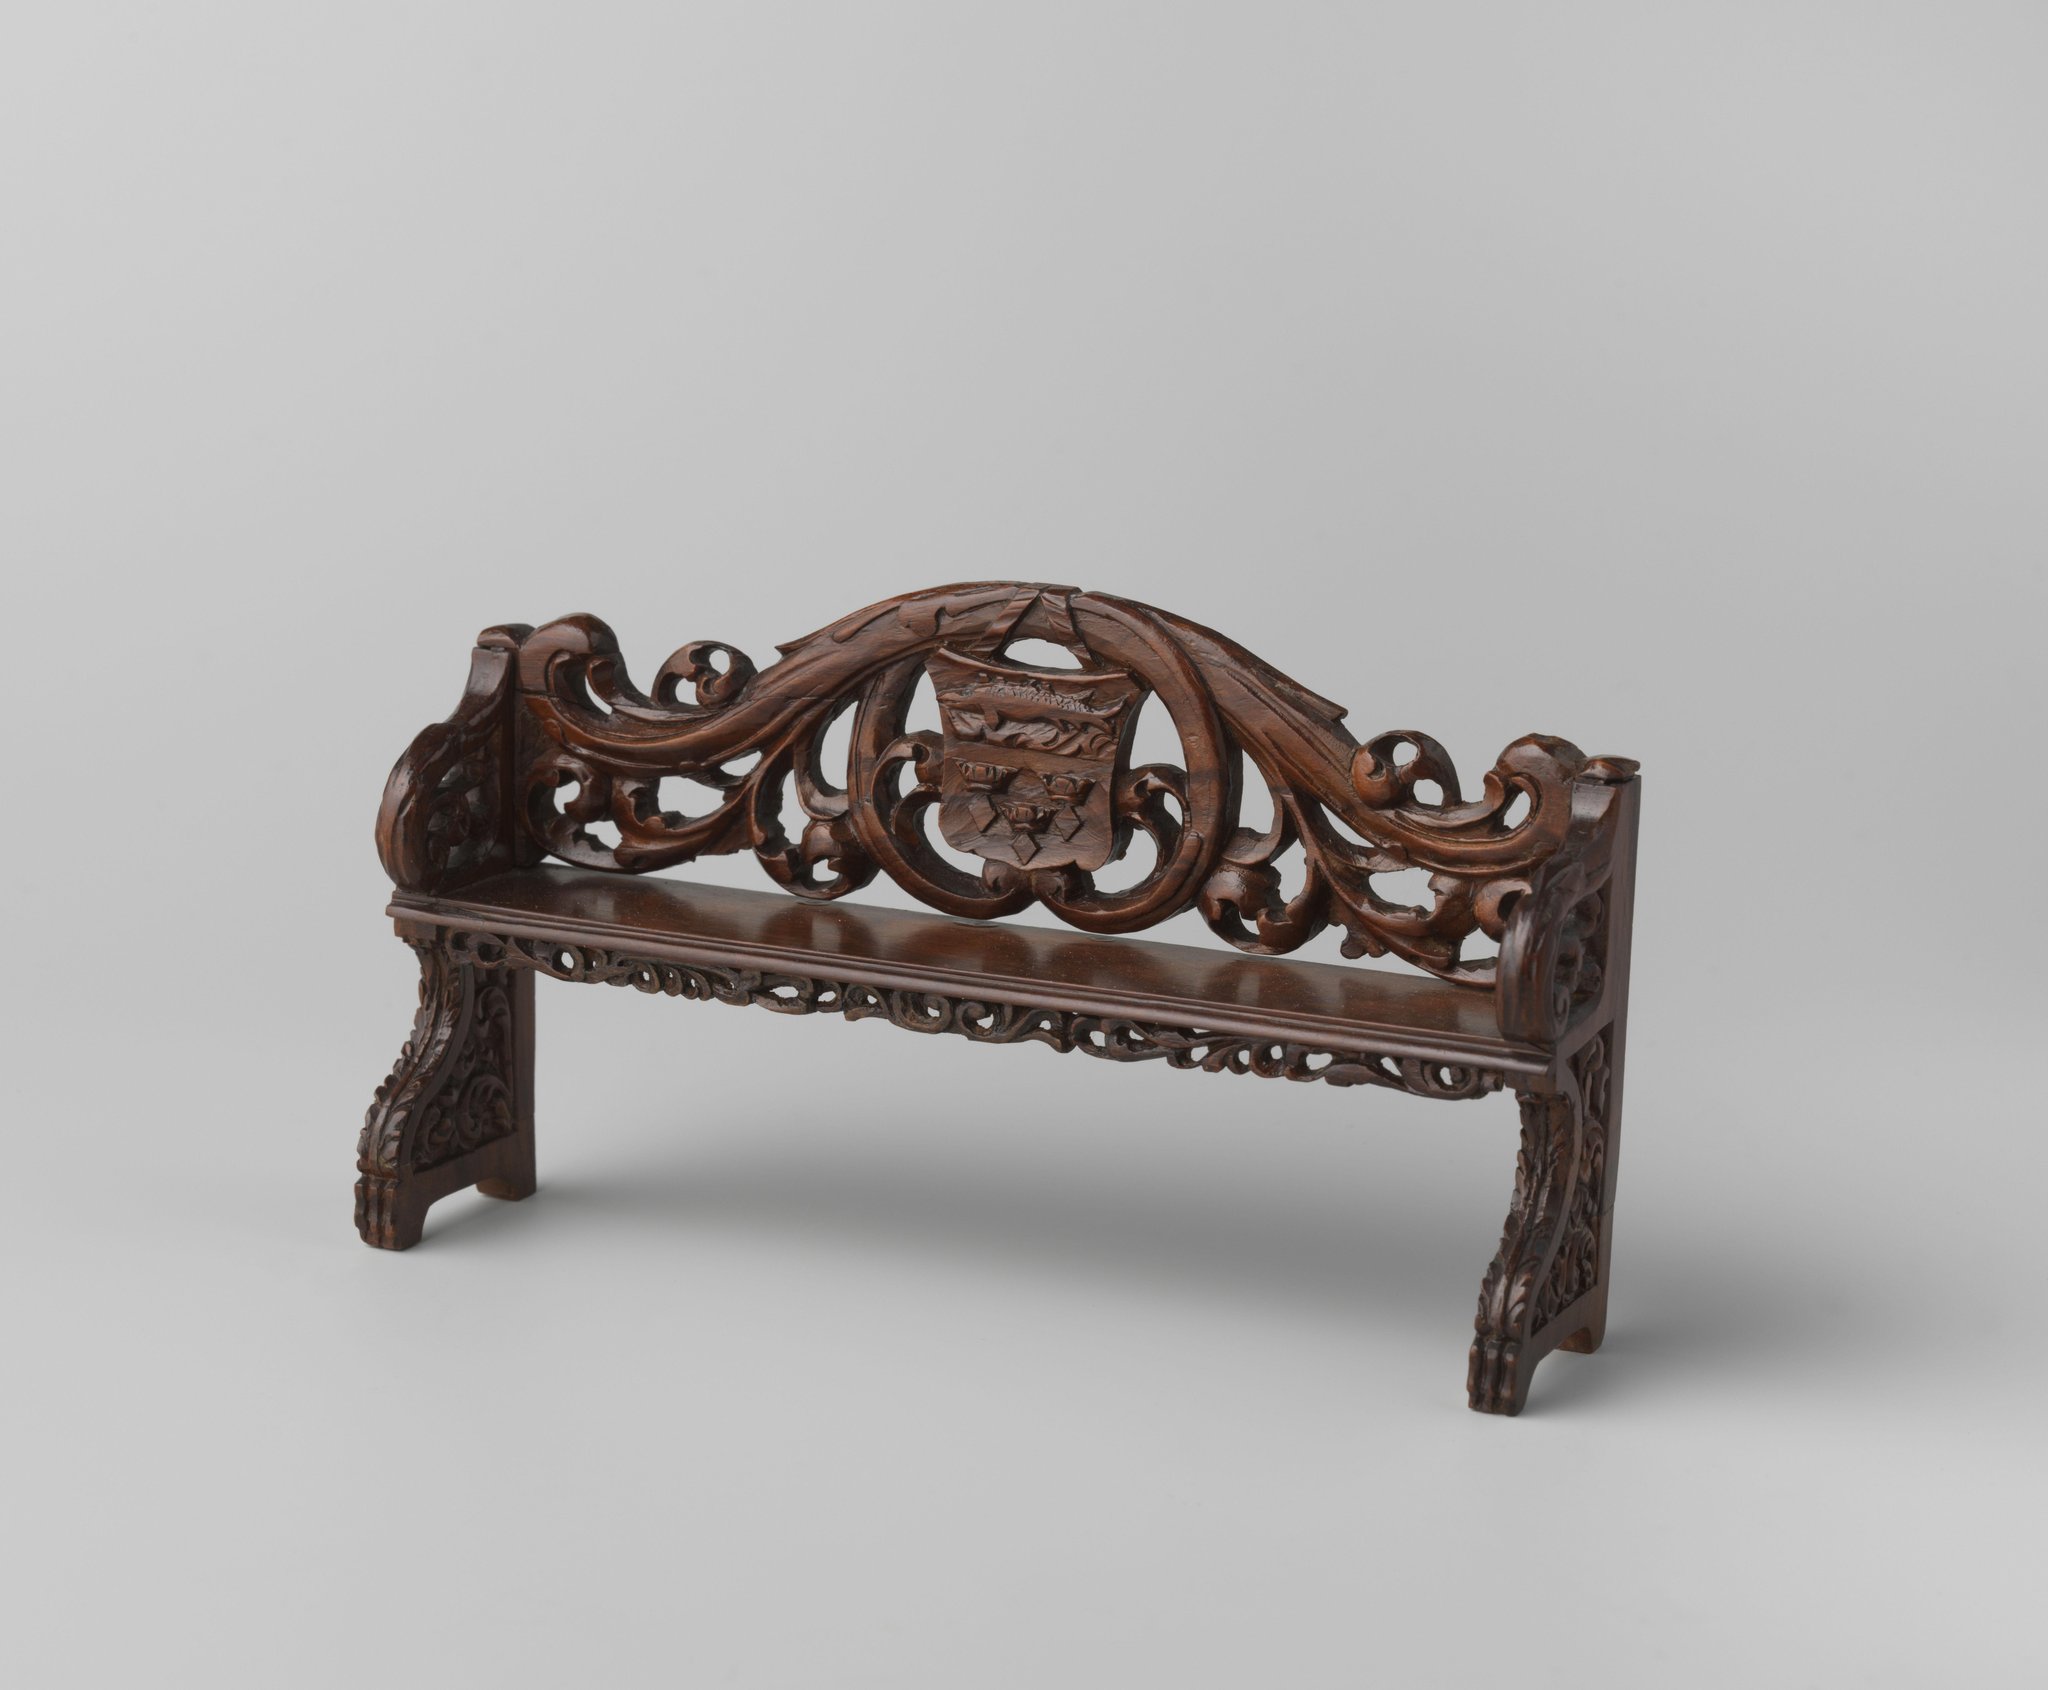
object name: miniature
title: Gangbank vervaardigd van olijfhout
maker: Anonymous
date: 1690-1710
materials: wood